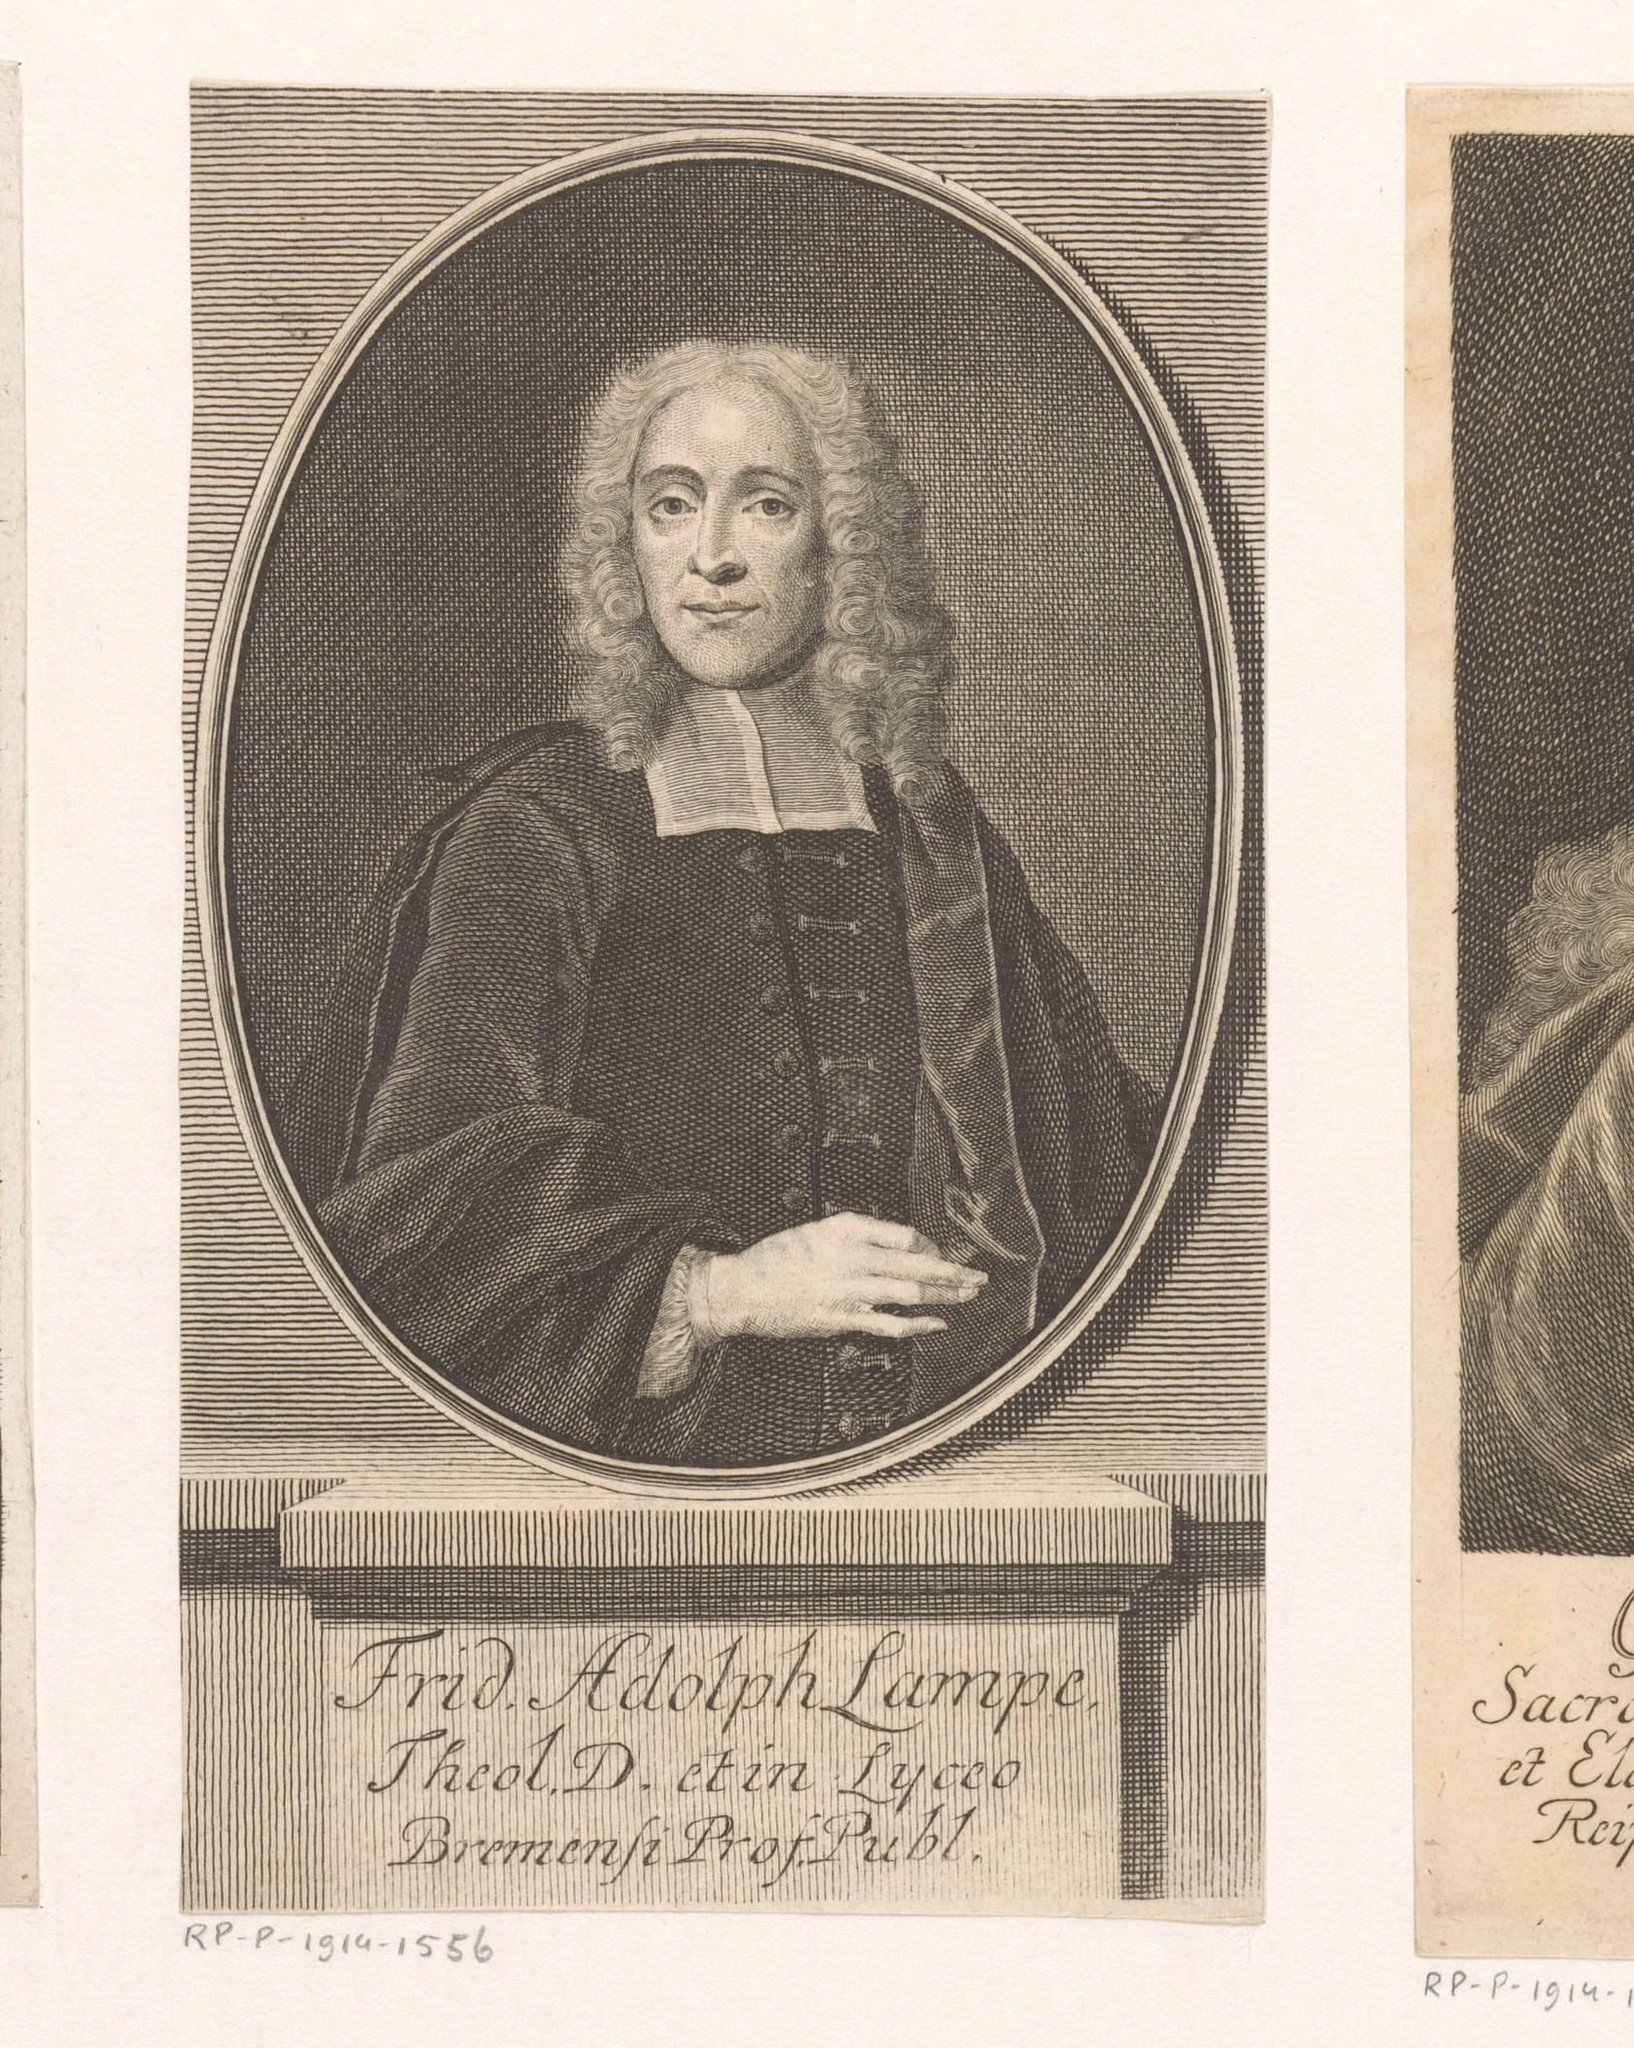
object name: print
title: Portret van Friedrich Adolph Lampe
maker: martin bernigeroth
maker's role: print maker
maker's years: 1670-1733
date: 1731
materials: paper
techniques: engraving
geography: leipzig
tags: historical persons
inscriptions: collector's mark: Lugt 2228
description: Prent ook gebruikt in: Deutsche Acta Eruditorum (...). dl. 160. Leipzig: Johann Gottlieb Gleditsch, 1731.